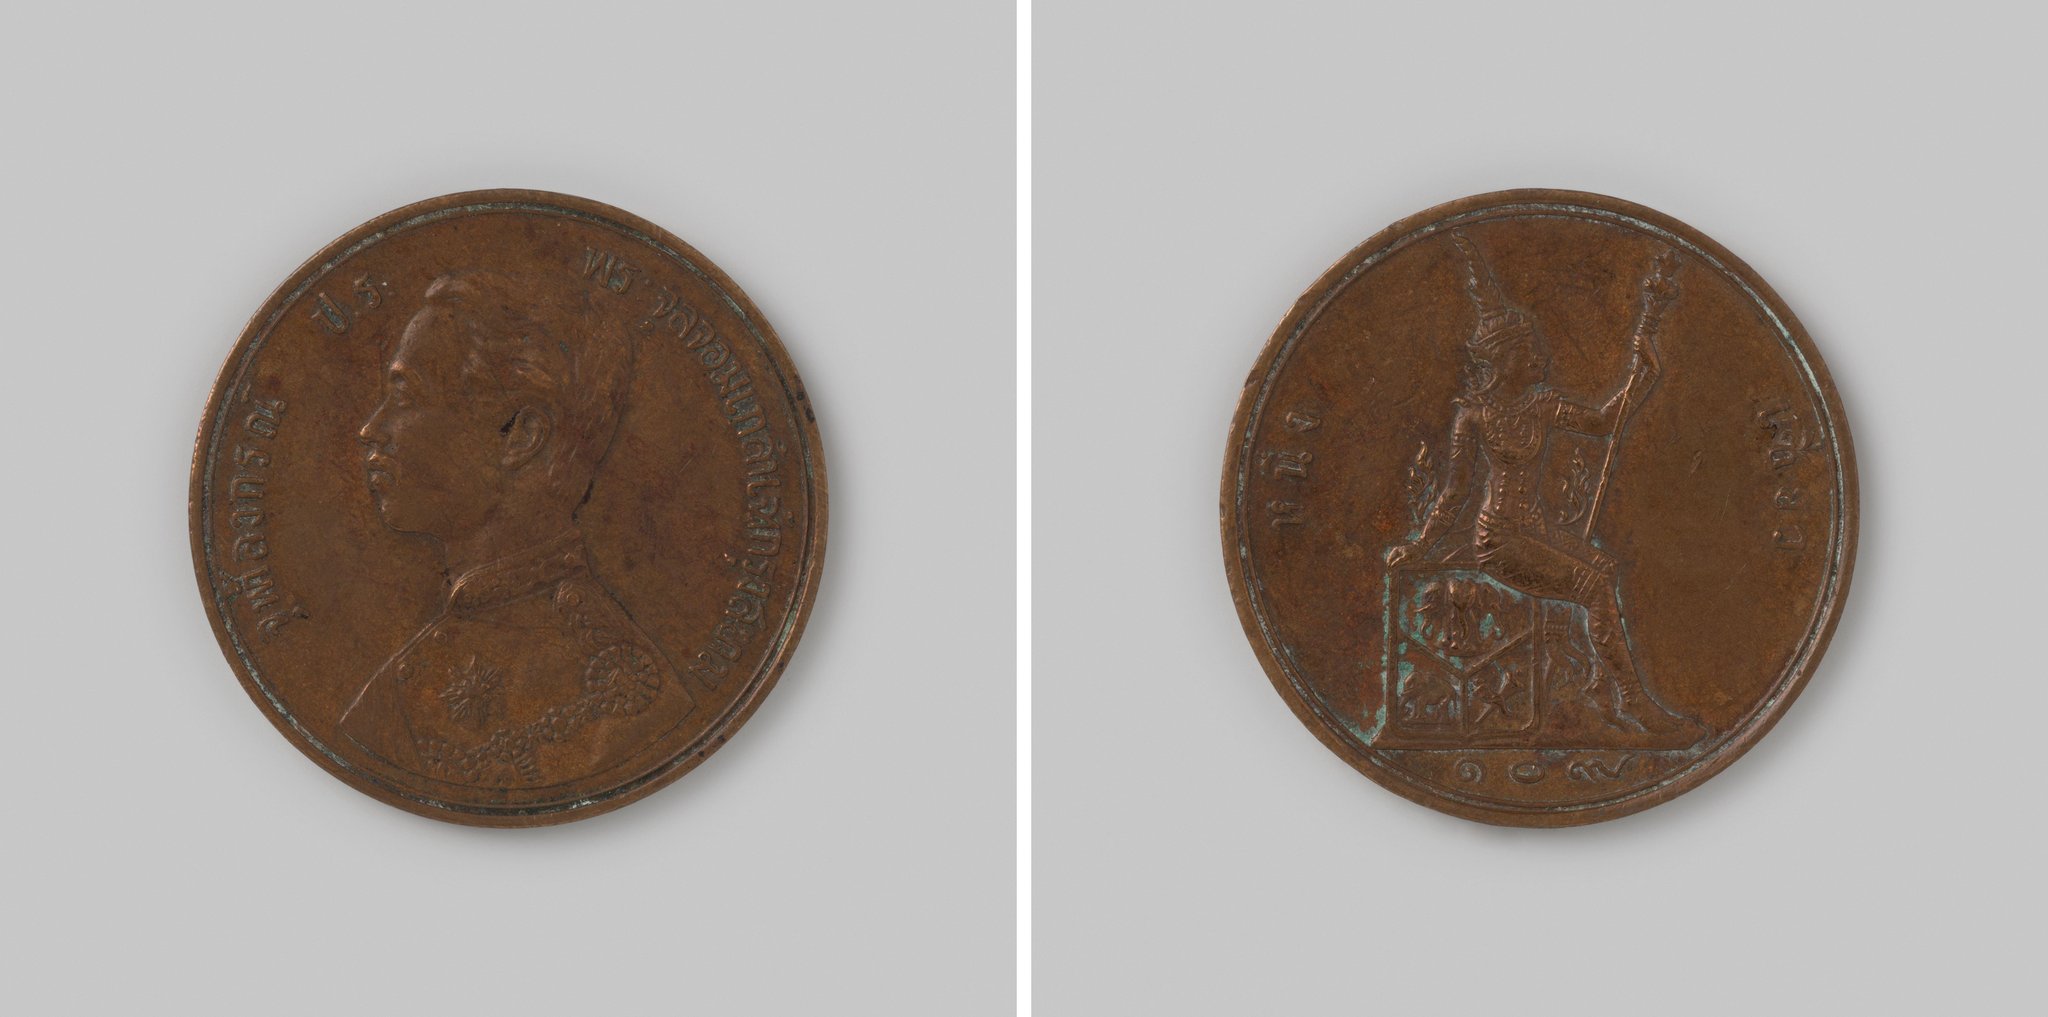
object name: coin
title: 2 att uit Thailand van koning Chulalongkorn, 109 [=1890]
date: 1890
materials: copper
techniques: striking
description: Koperen munt. Voorzijde: borstbeeld van de koning naar links. Keerzijde: Siam naar rechts met staf, gezeten op het Thaise wapenschild. Waarde-aanduiding rondom. In afsnede jaartal in telling van Bangkok: 109. Gladde rand.